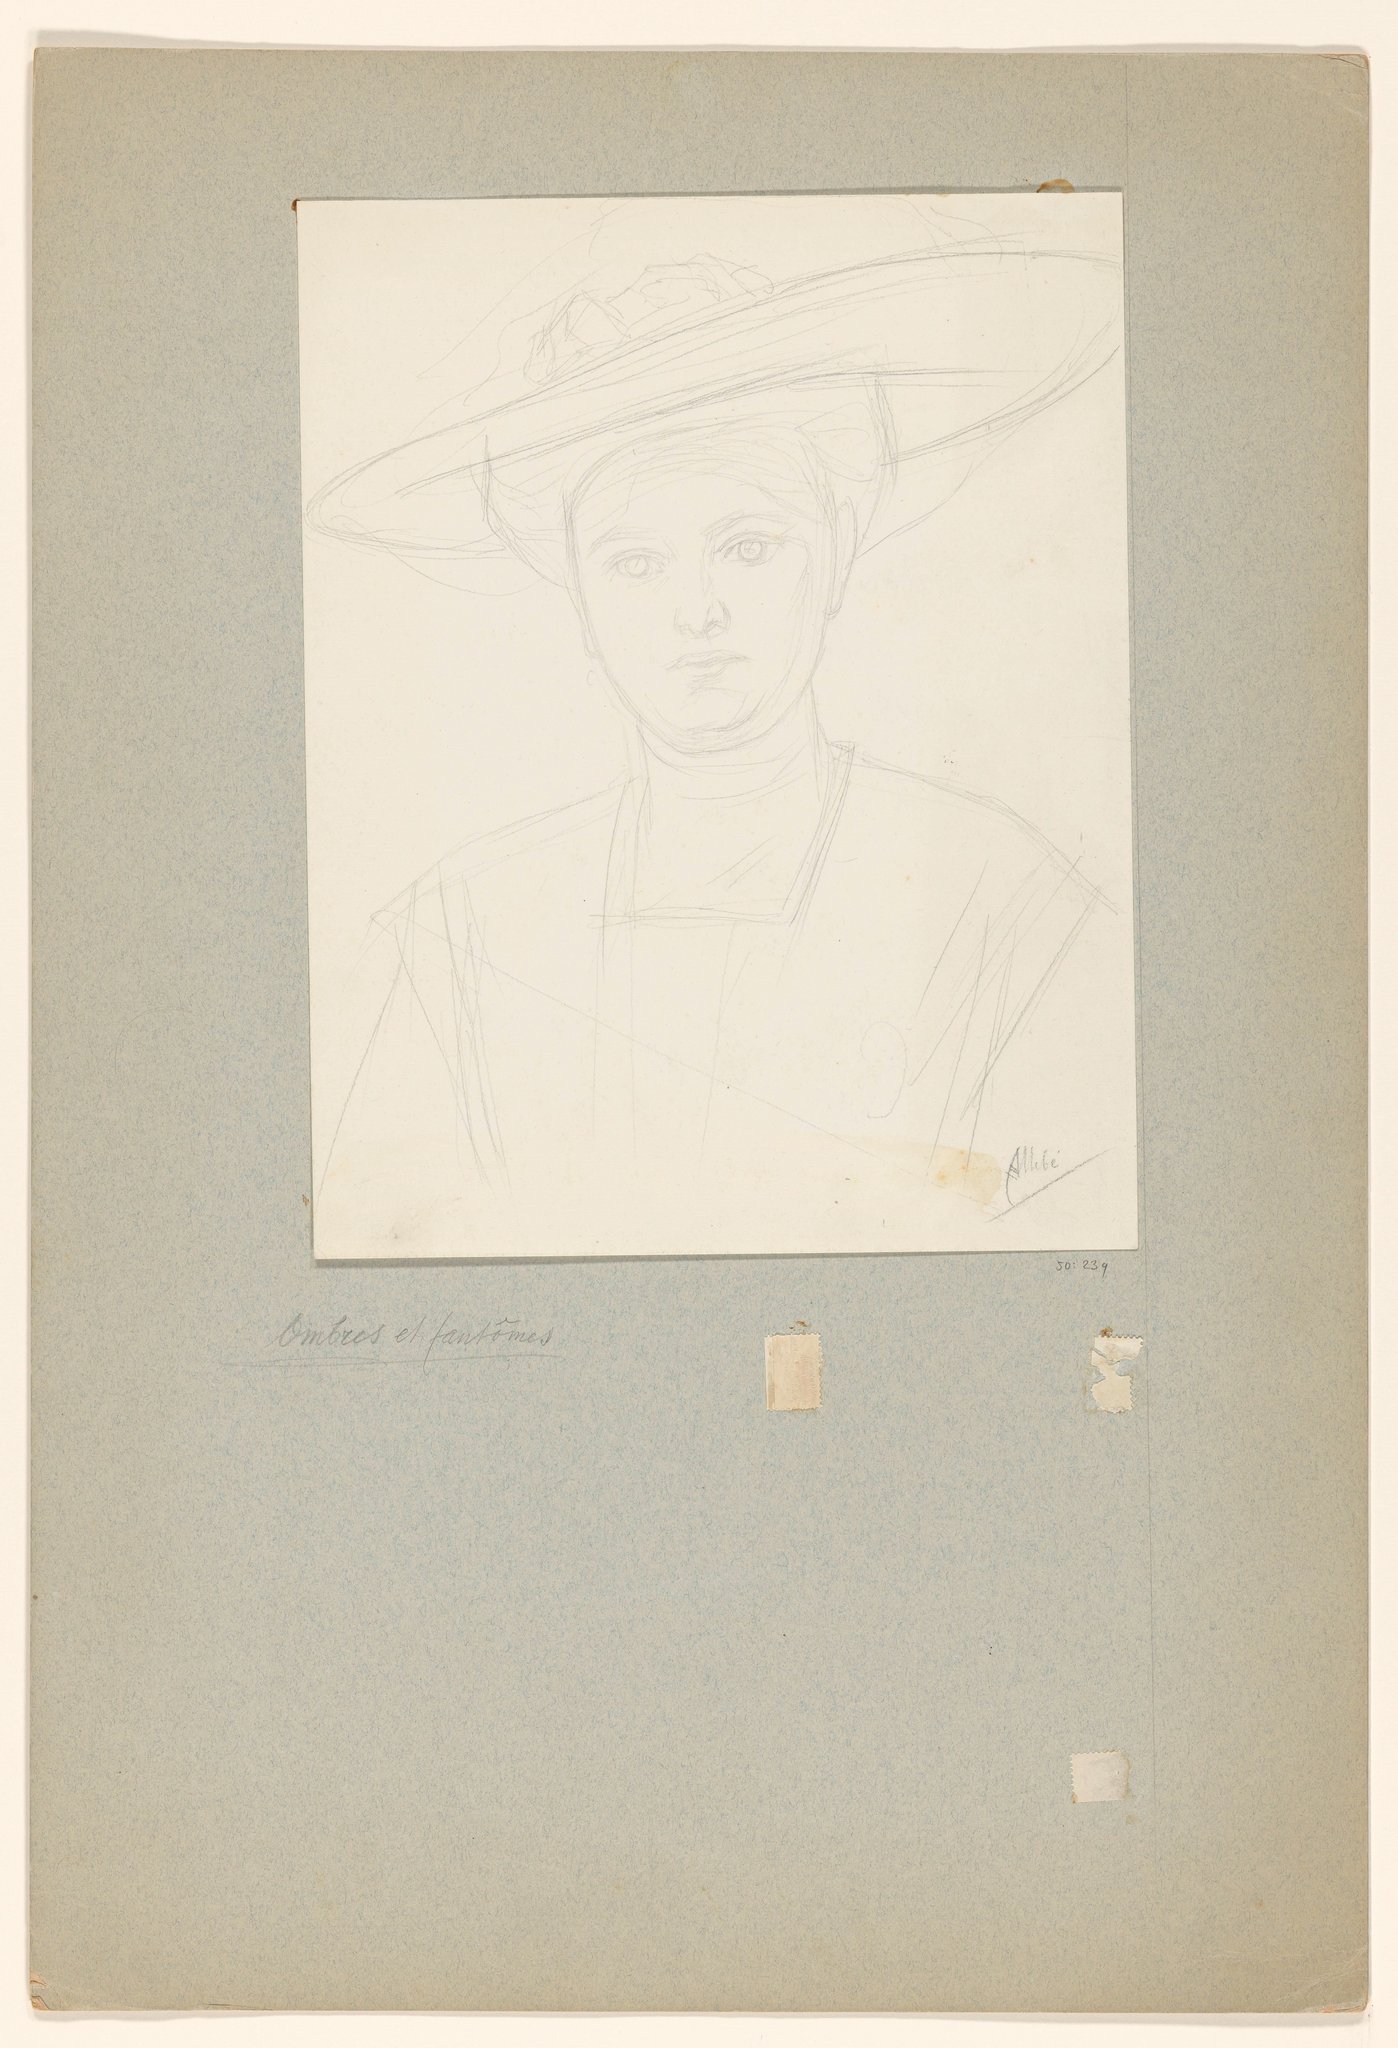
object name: drawing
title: Portret van een vrouw met een hoed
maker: august allebé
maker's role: draughtsman, print maker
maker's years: 1838-1927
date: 1848-1927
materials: paper, pencil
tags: anonymous historical person portrayed alone, female sex; woman